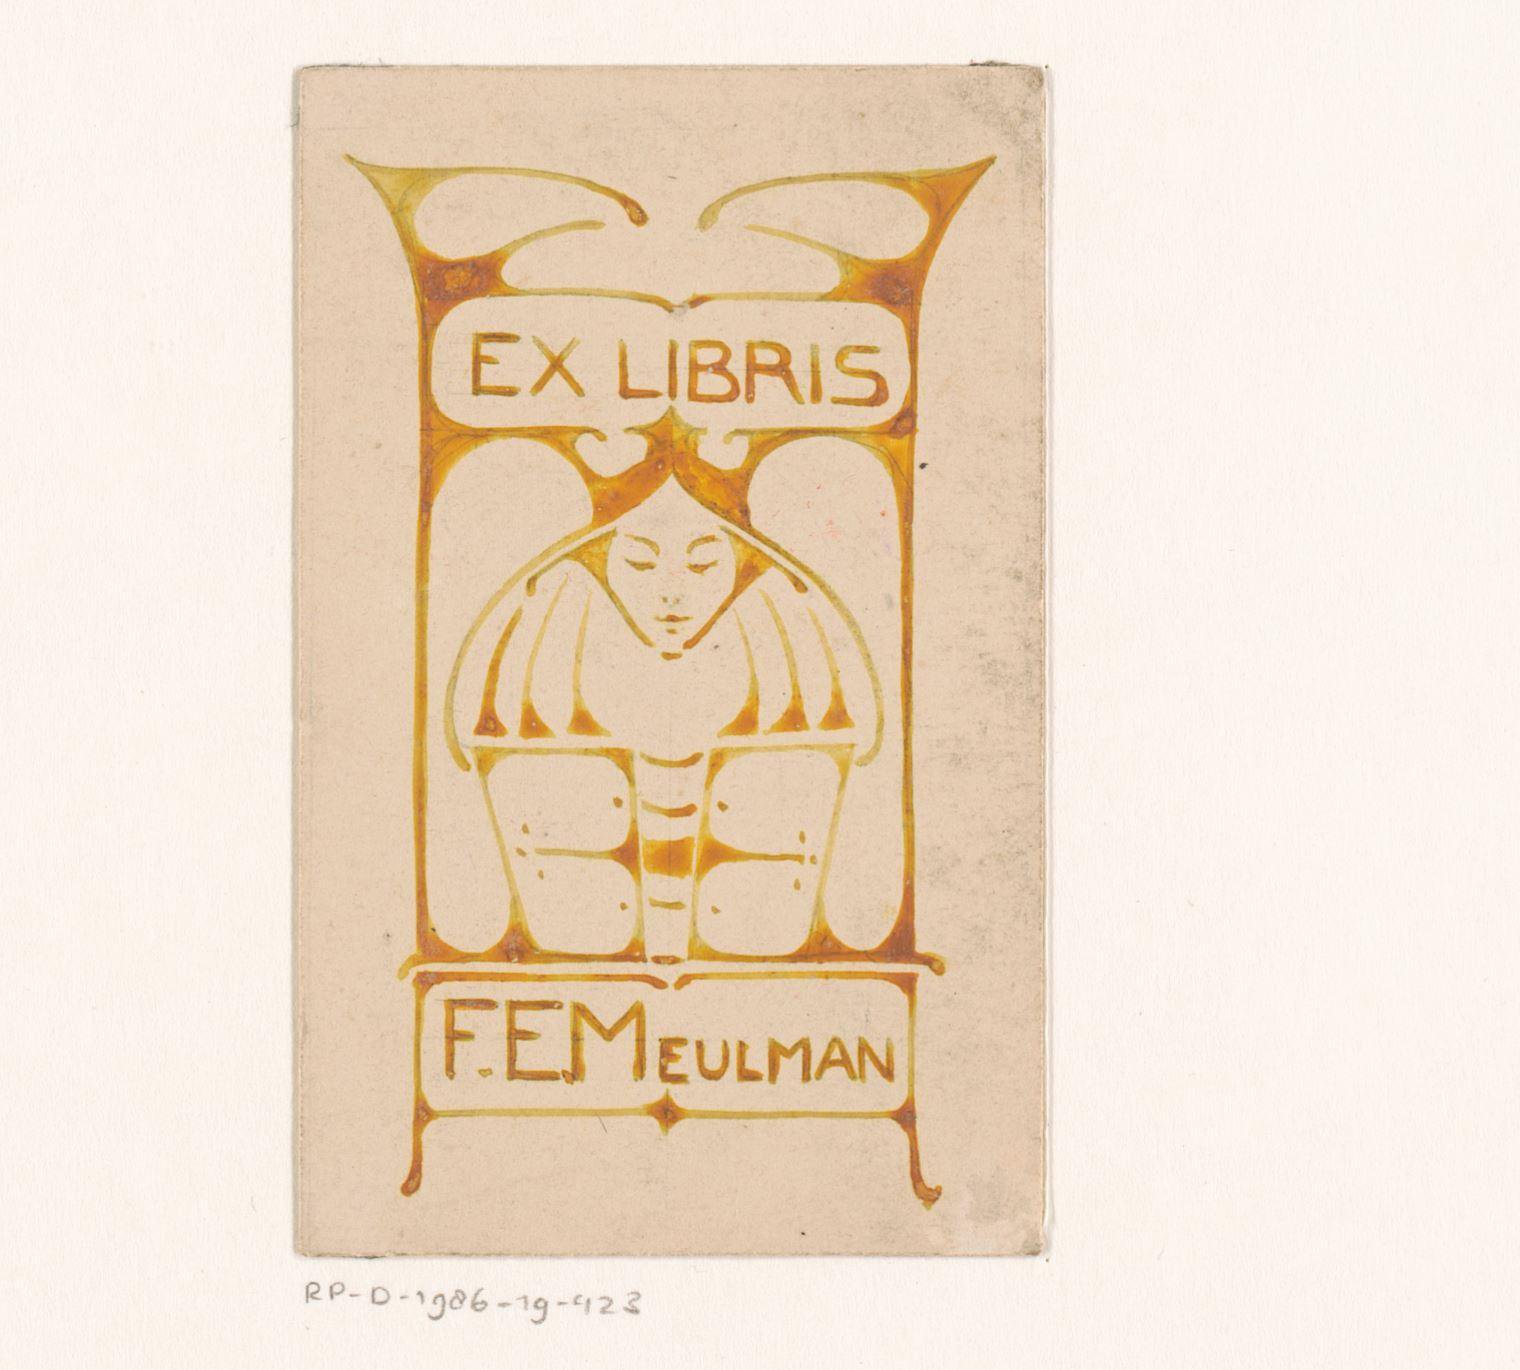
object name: drawing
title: Ontwerp voor een ex libris van F.E. Meulman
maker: reinier willem petrus de vries (1874-1953)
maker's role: draughtsman, print maker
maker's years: 1874-1953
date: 1884-1952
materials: ink, paper, pencil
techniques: brush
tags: head (human), ornaments ~ art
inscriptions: collector's mark: ‘R:MVS.’